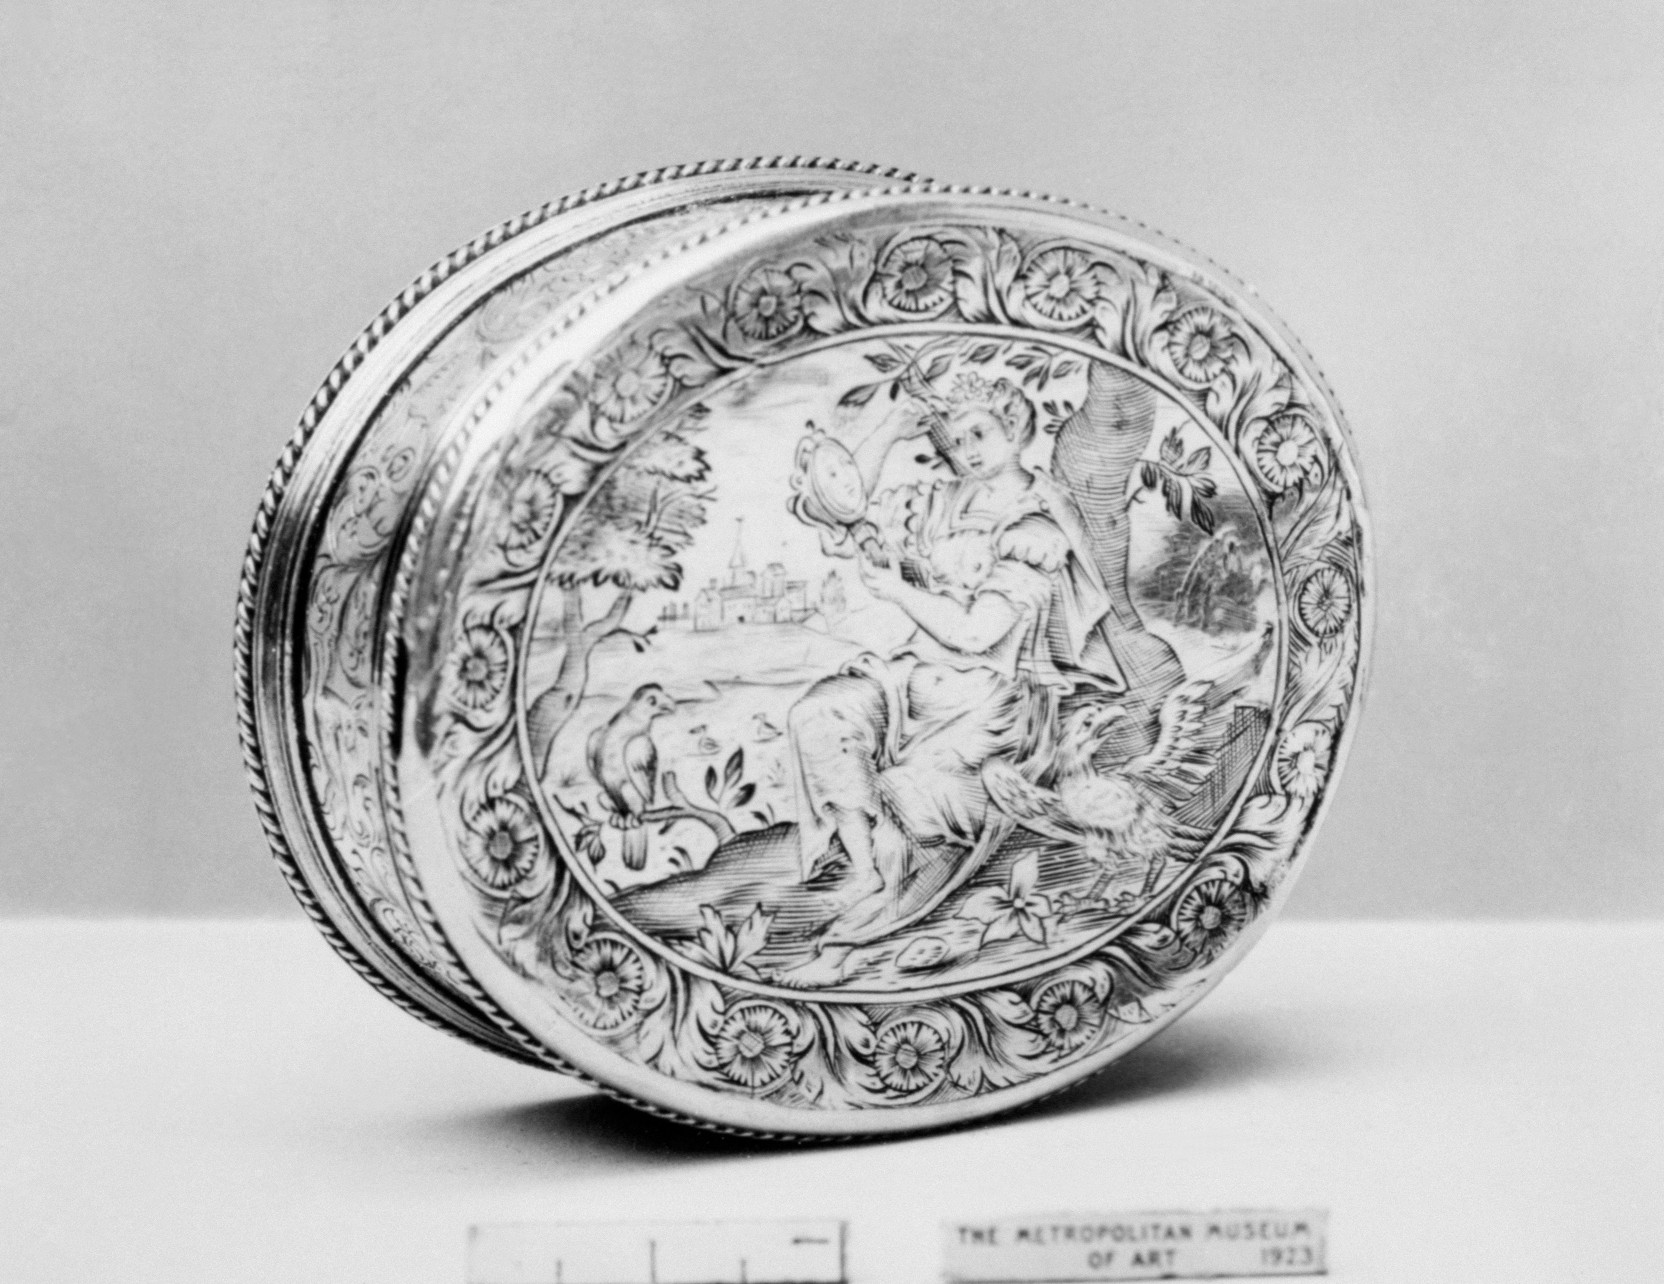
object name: patch box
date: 1734-1766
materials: silver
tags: birds,women,flowers,trees